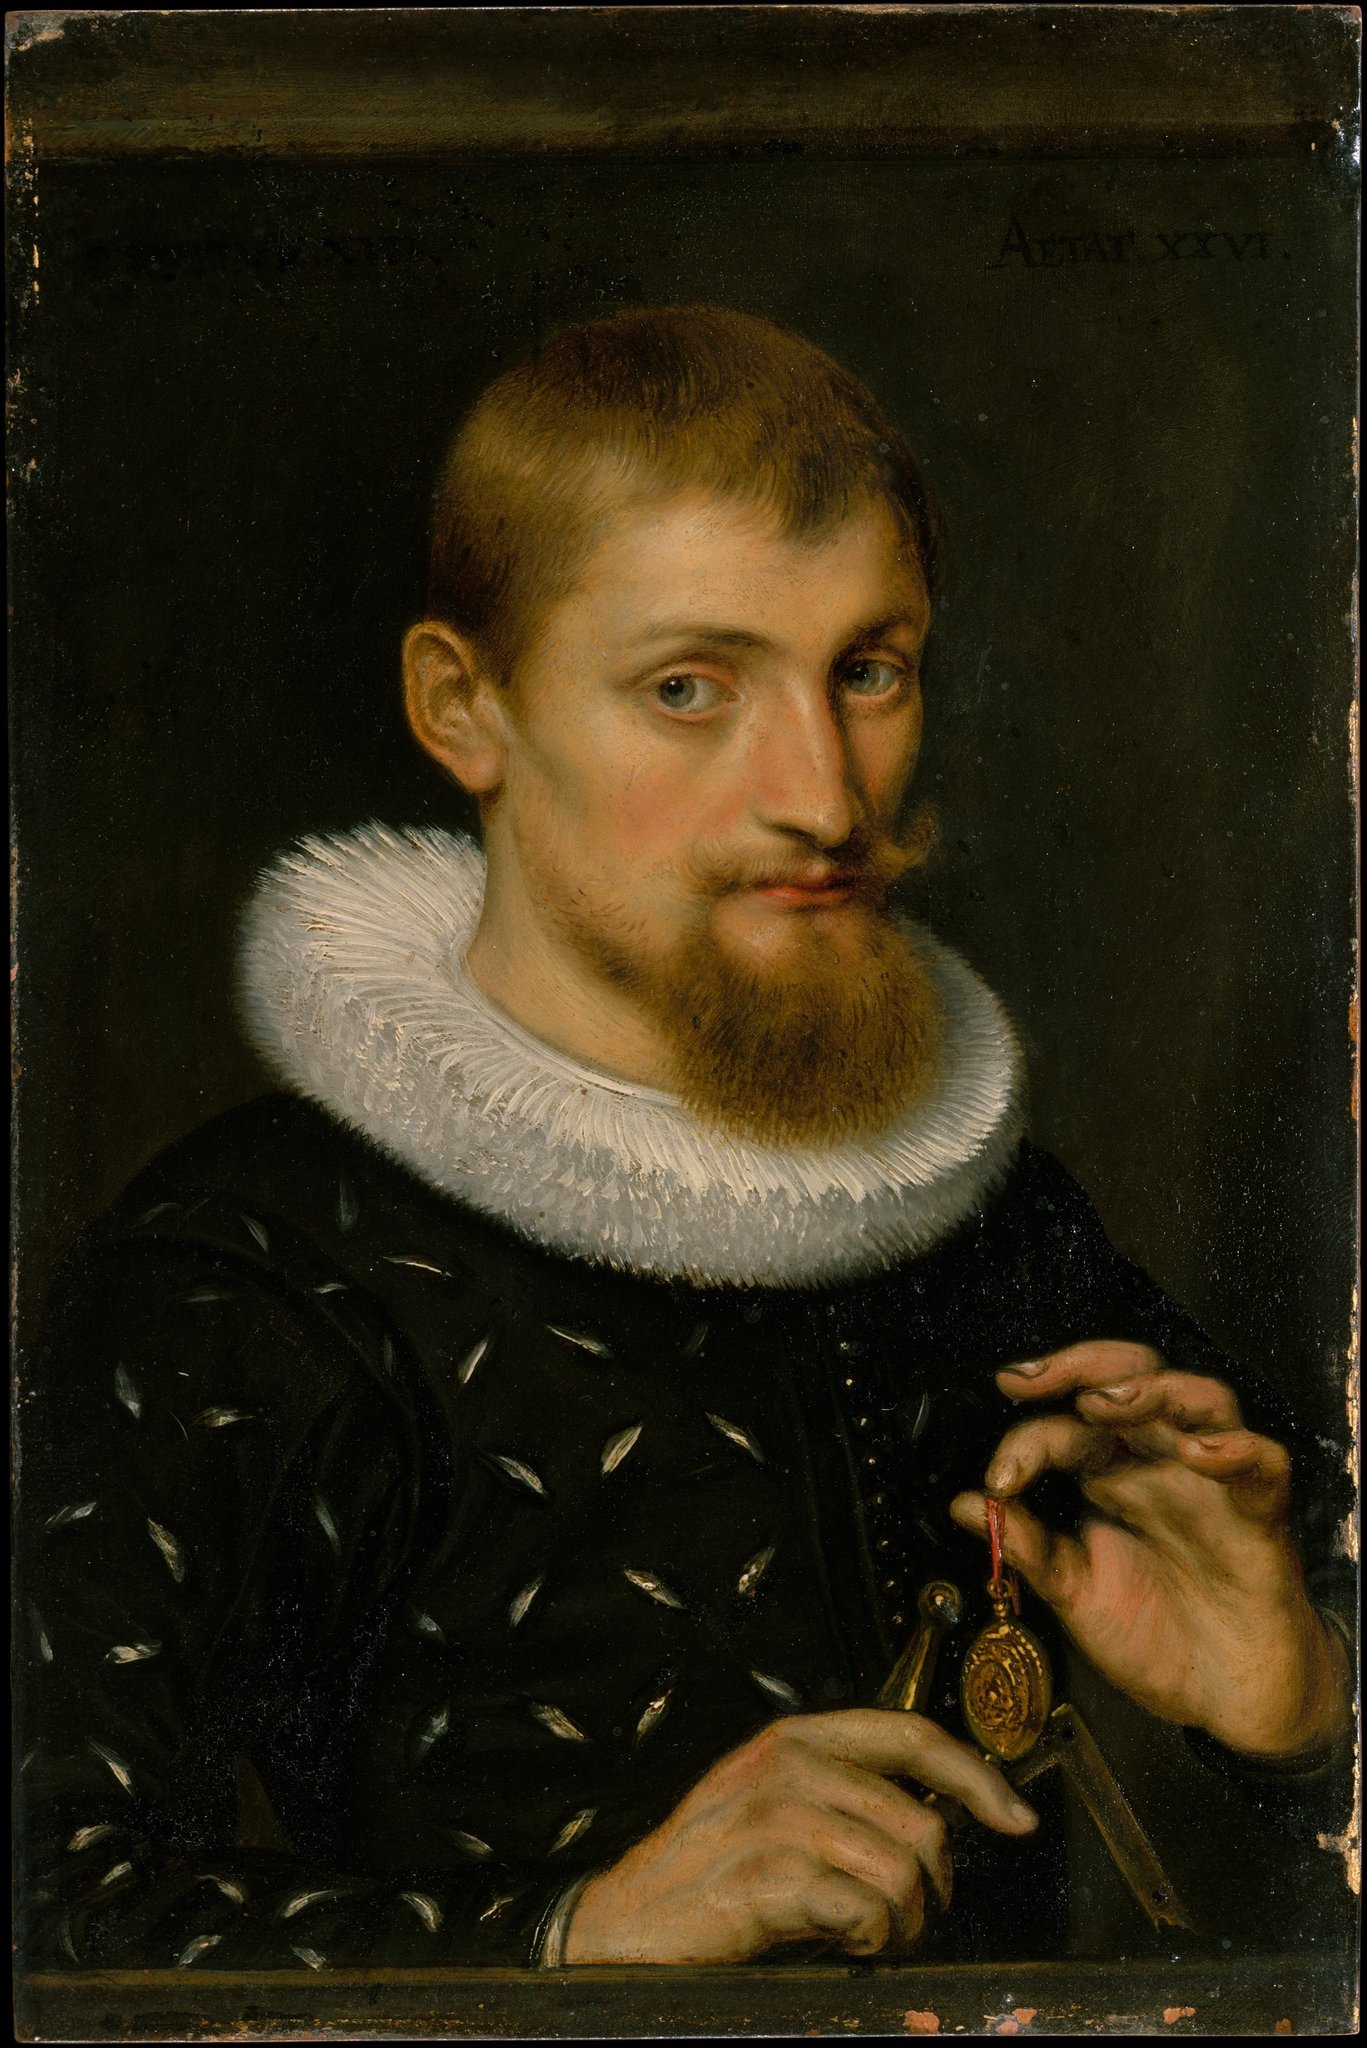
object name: painting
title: Portrait of a Man, Possibly an Architect or Geographer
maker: peter paul rubens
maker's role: artist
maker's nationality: flemish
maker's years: 1577-1640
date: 1597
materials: copper, oil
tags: men,portraits